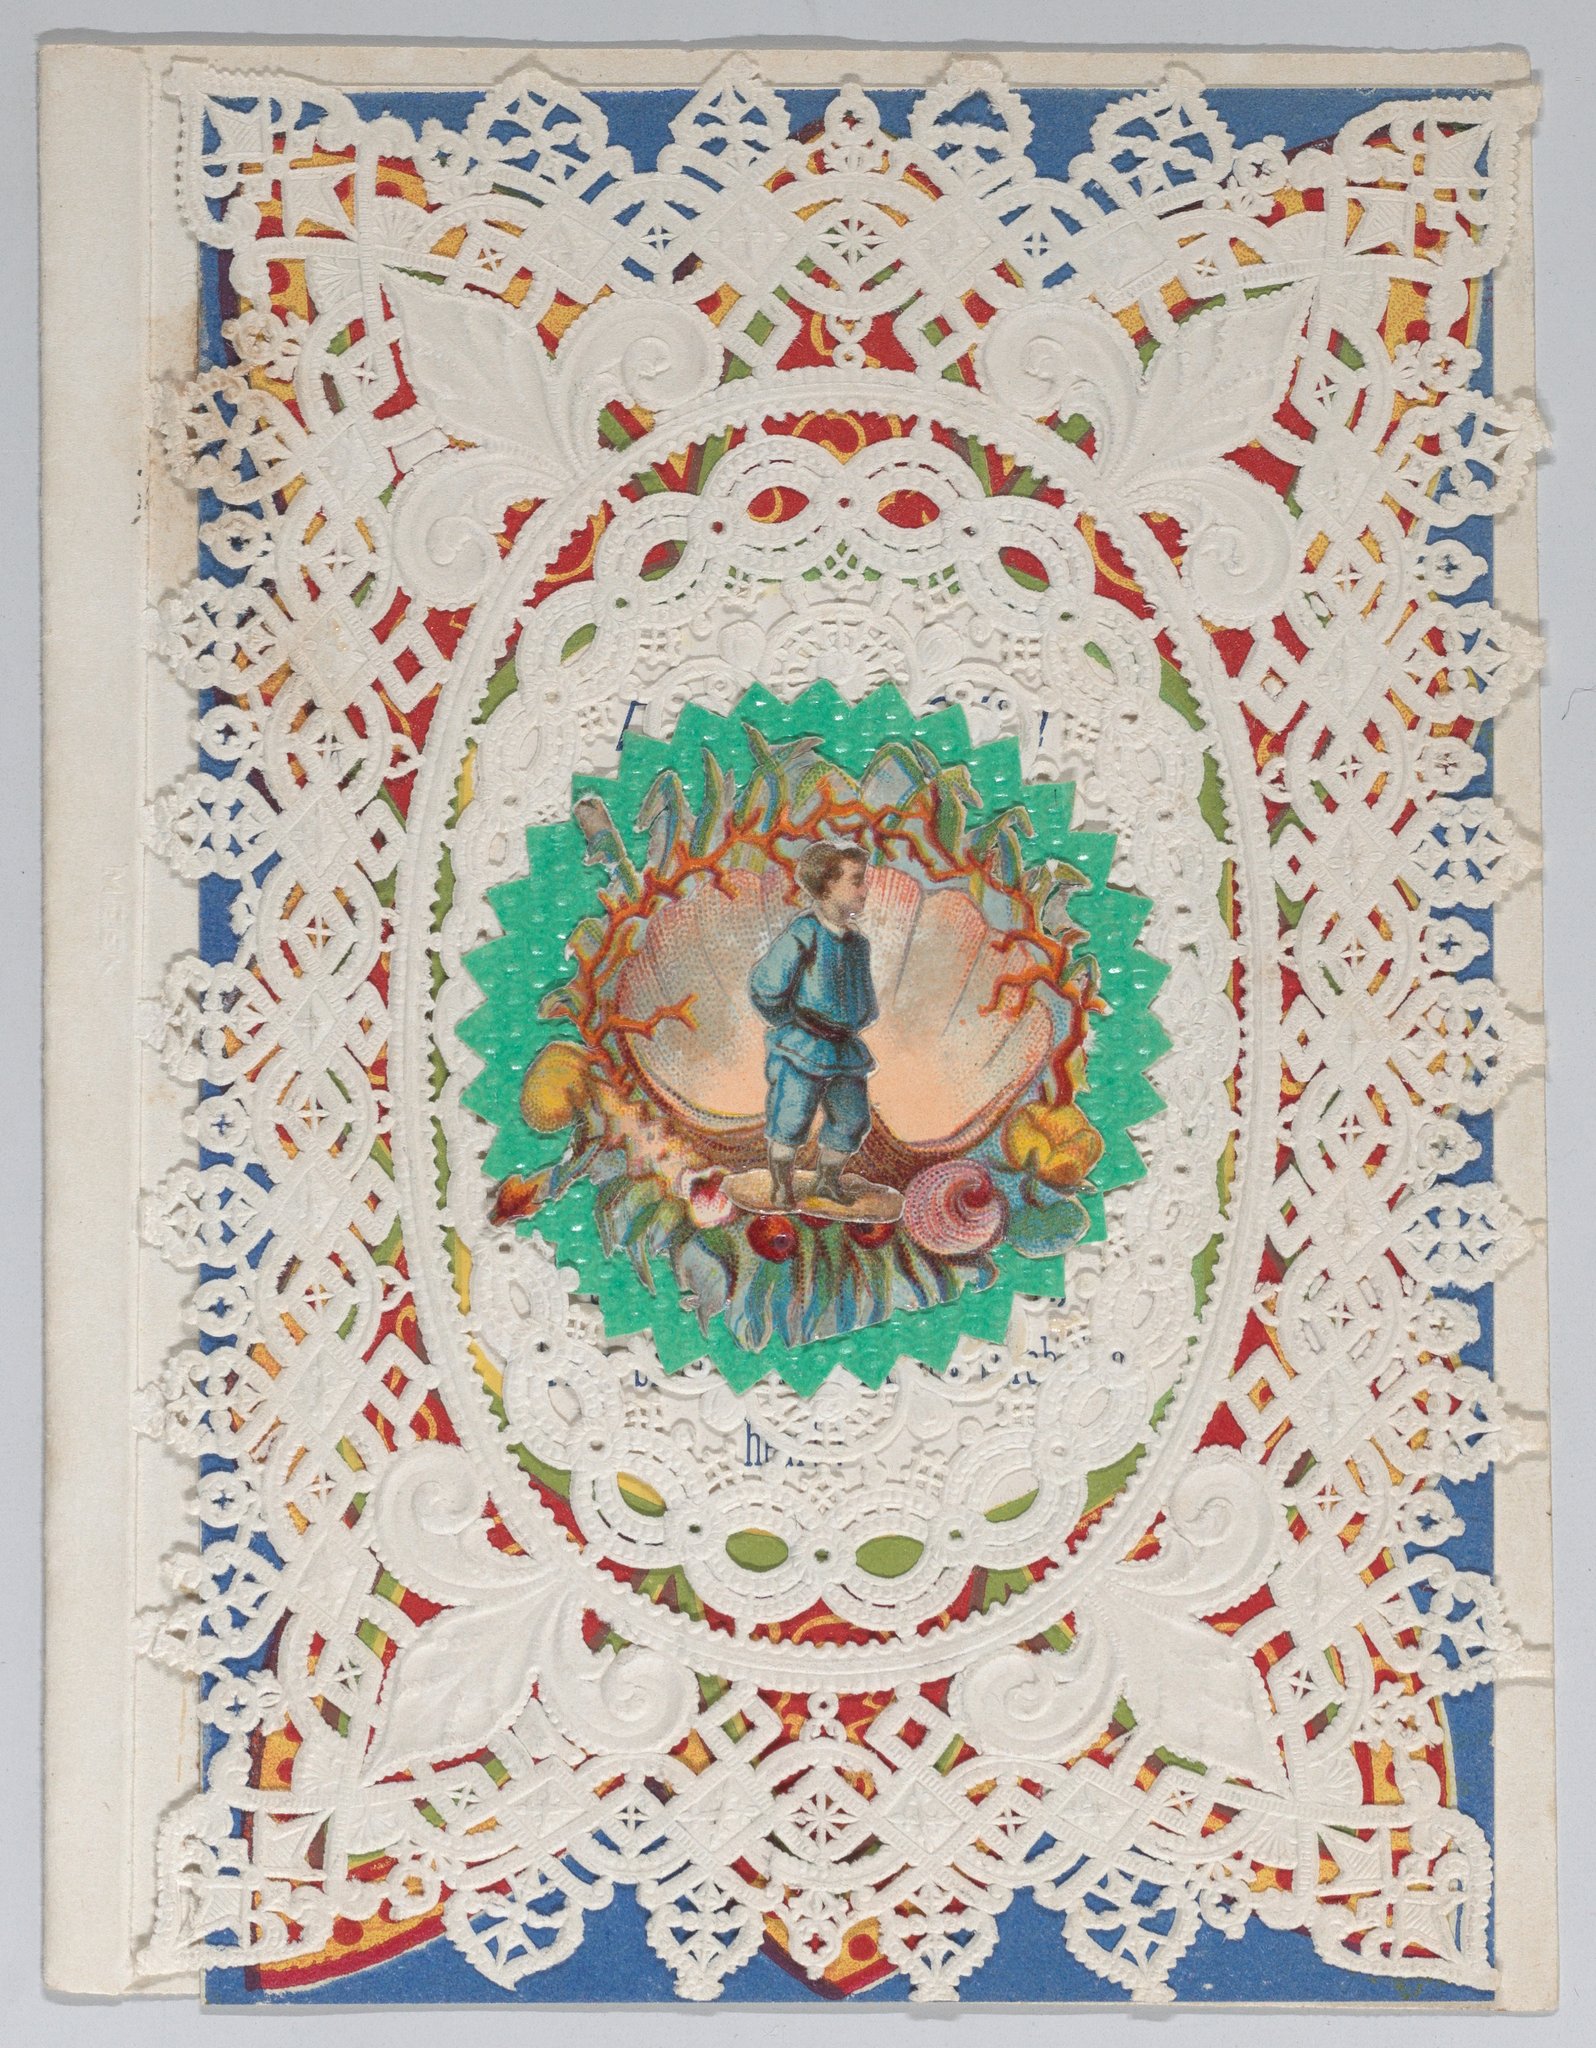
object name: valentine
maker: Anonymous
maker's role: artist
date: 1880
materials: lace, paper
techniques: chromolithography, embossing, open work